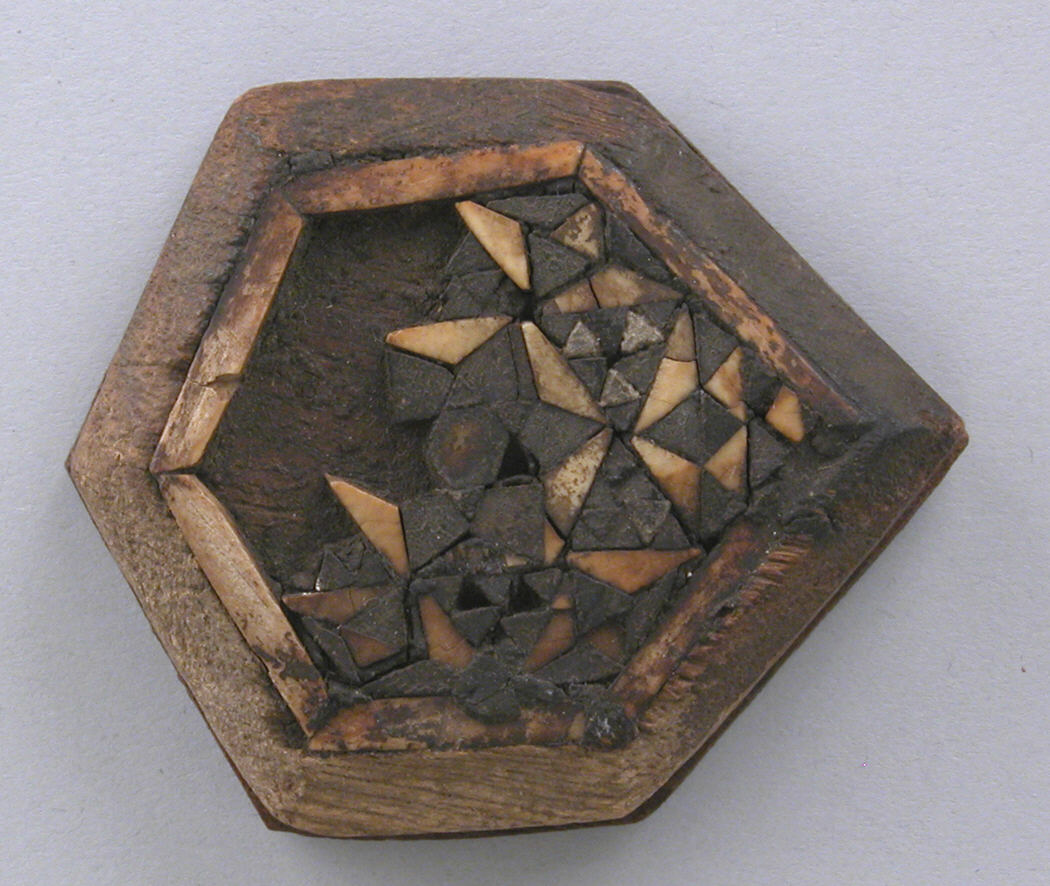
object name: panel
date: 1301-1500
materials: ivory, wood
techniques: inlay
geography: egypt